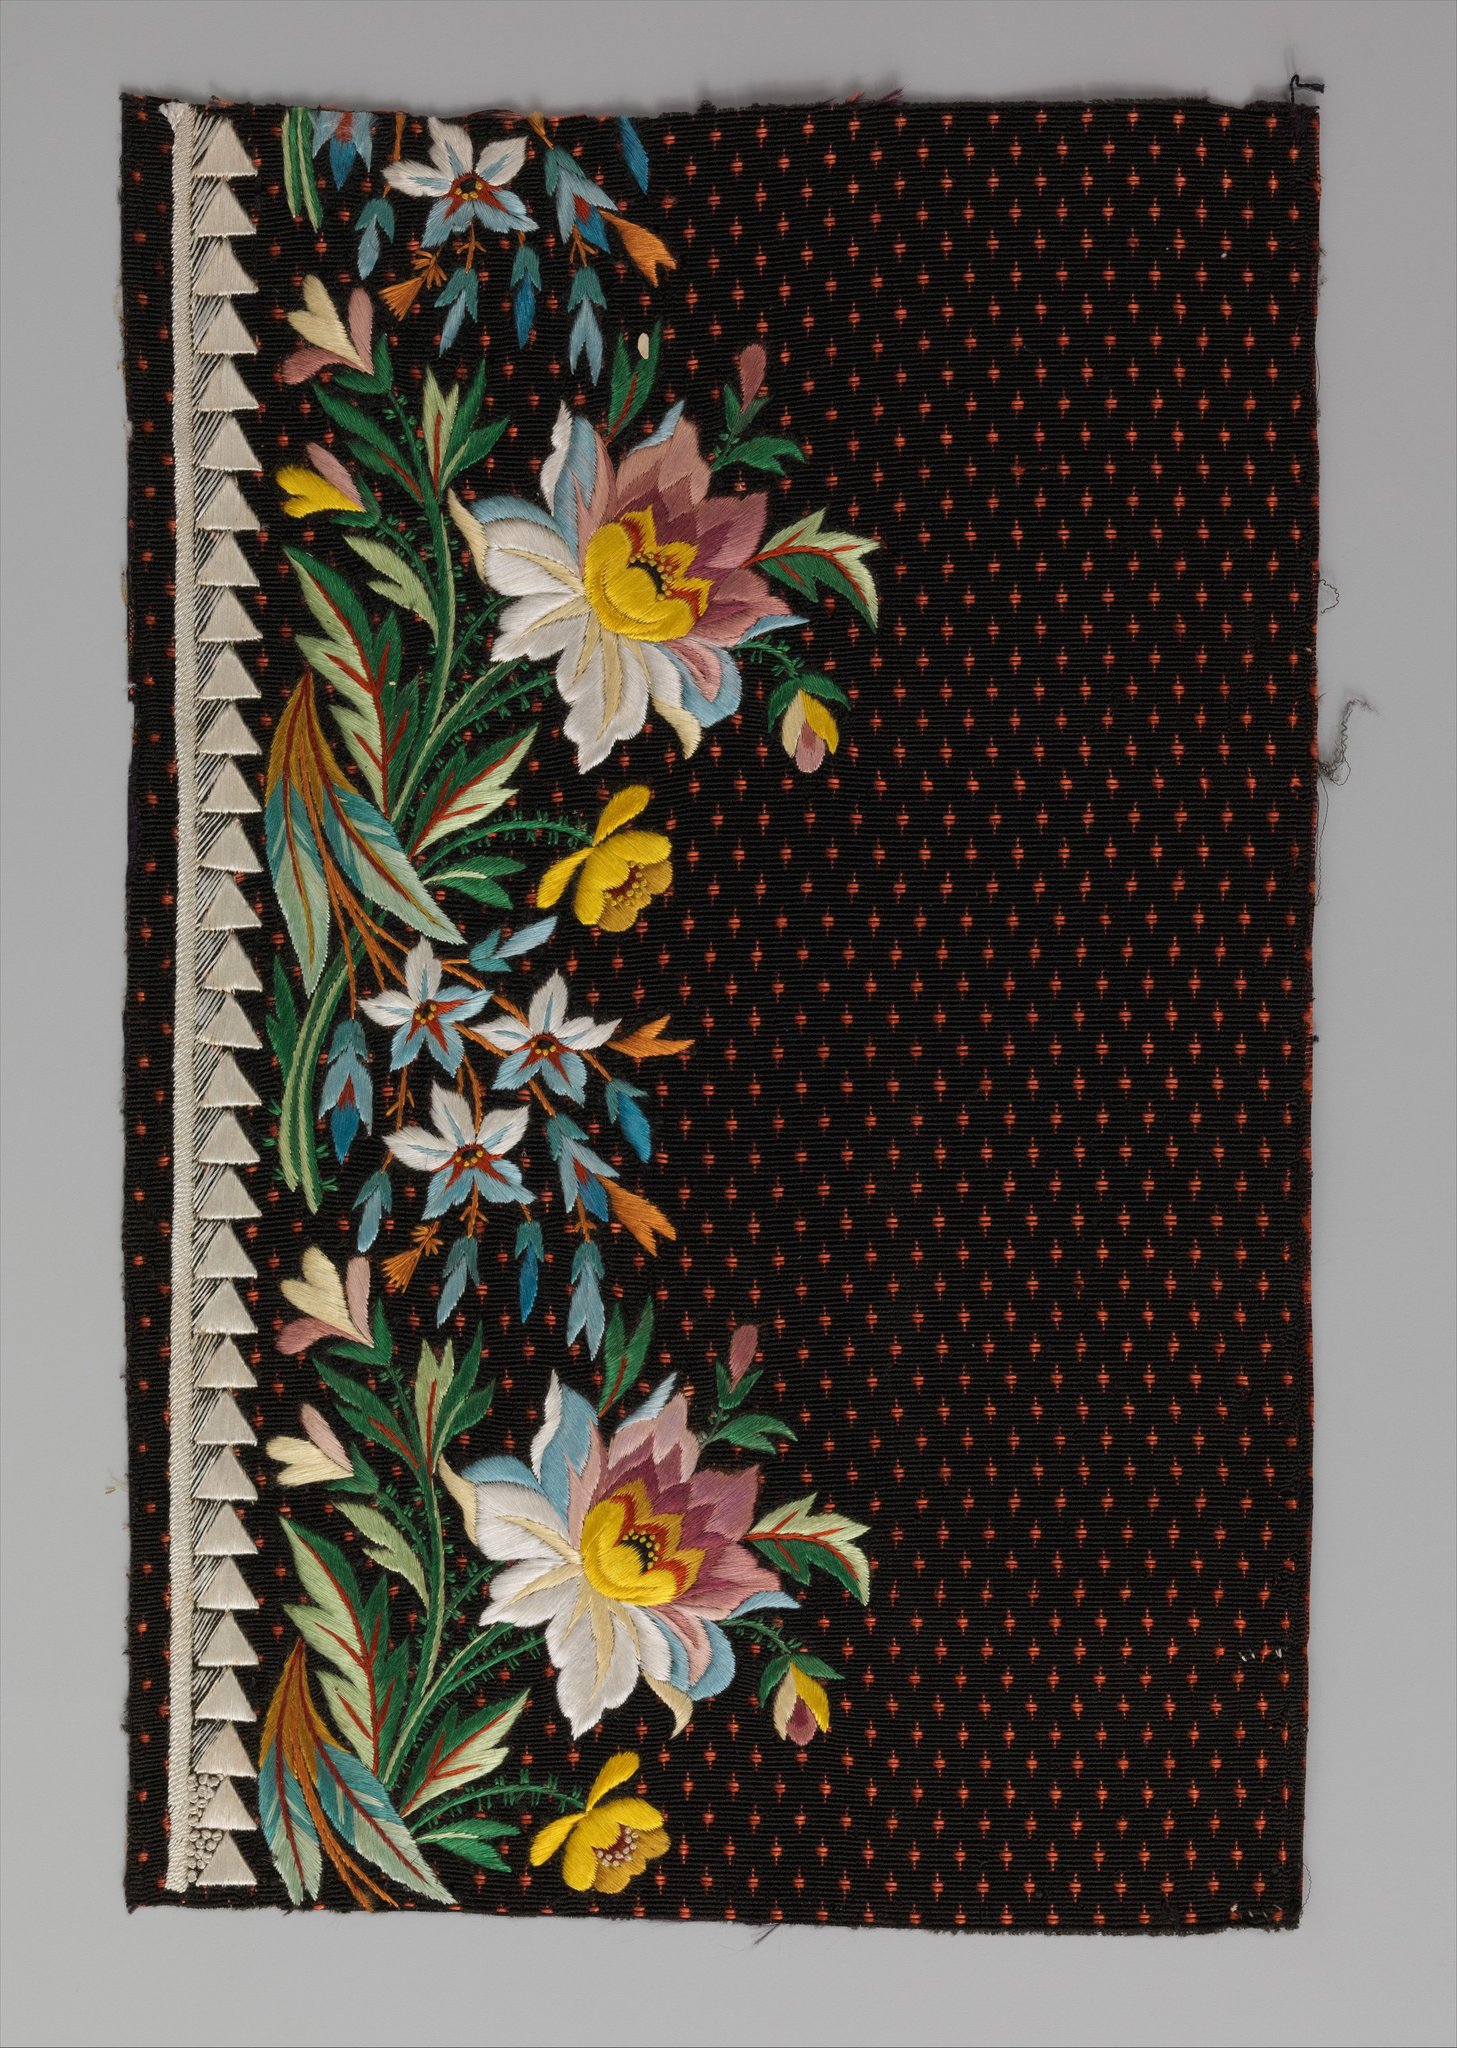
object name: sample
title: Embroidery sample for a man’s suit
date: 1800-1815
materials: silk, thread, velvet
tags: flowers